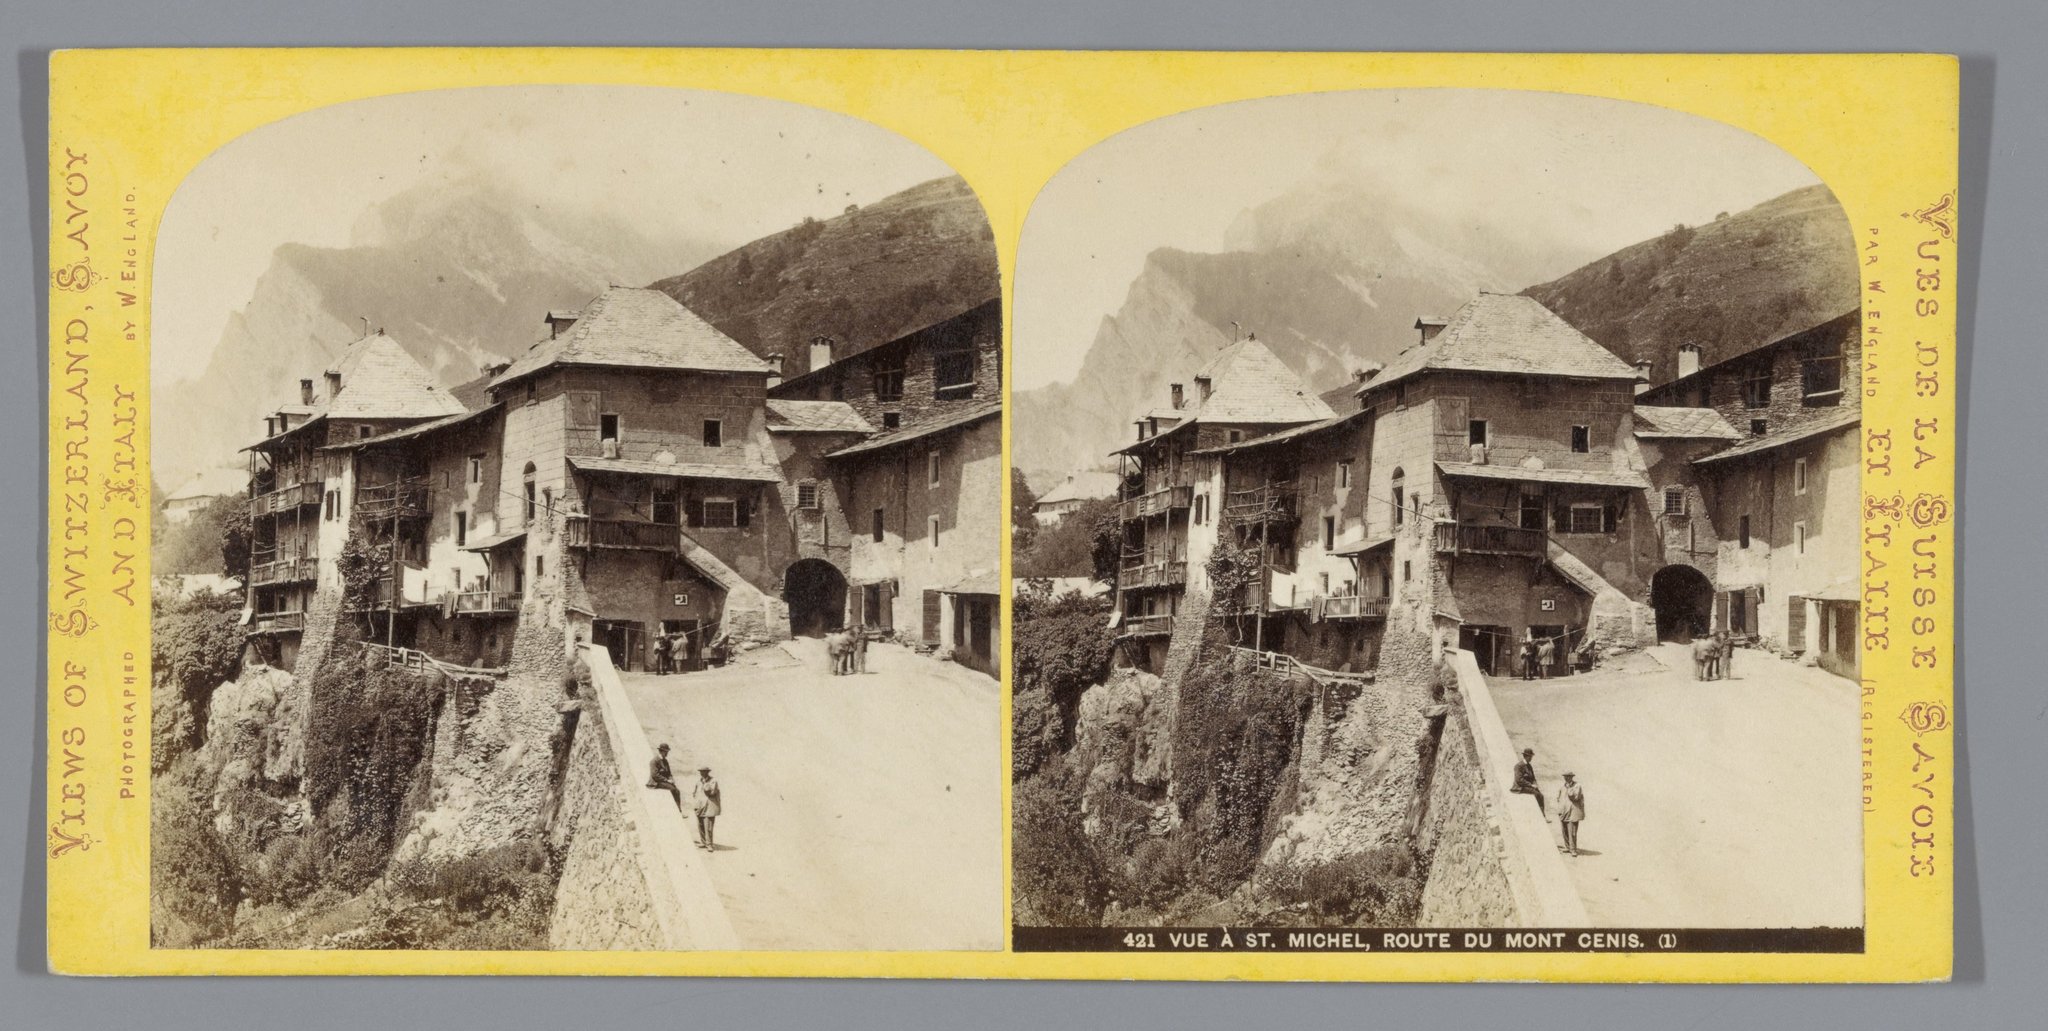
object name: stereograph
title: Gezicht op Saint-Michel-de-Maurienne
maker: william england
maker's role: fotograaf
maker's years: 1816-1896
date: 1850-1880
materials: cardboard, photographic support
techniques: albumen print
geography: saint-michel-de-maurienne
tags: prospect of city, town panorama, silhouette of city, mountains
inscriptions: number: ‘421’, inscription: ‘Vues de la Suisse Savoie et Italie’